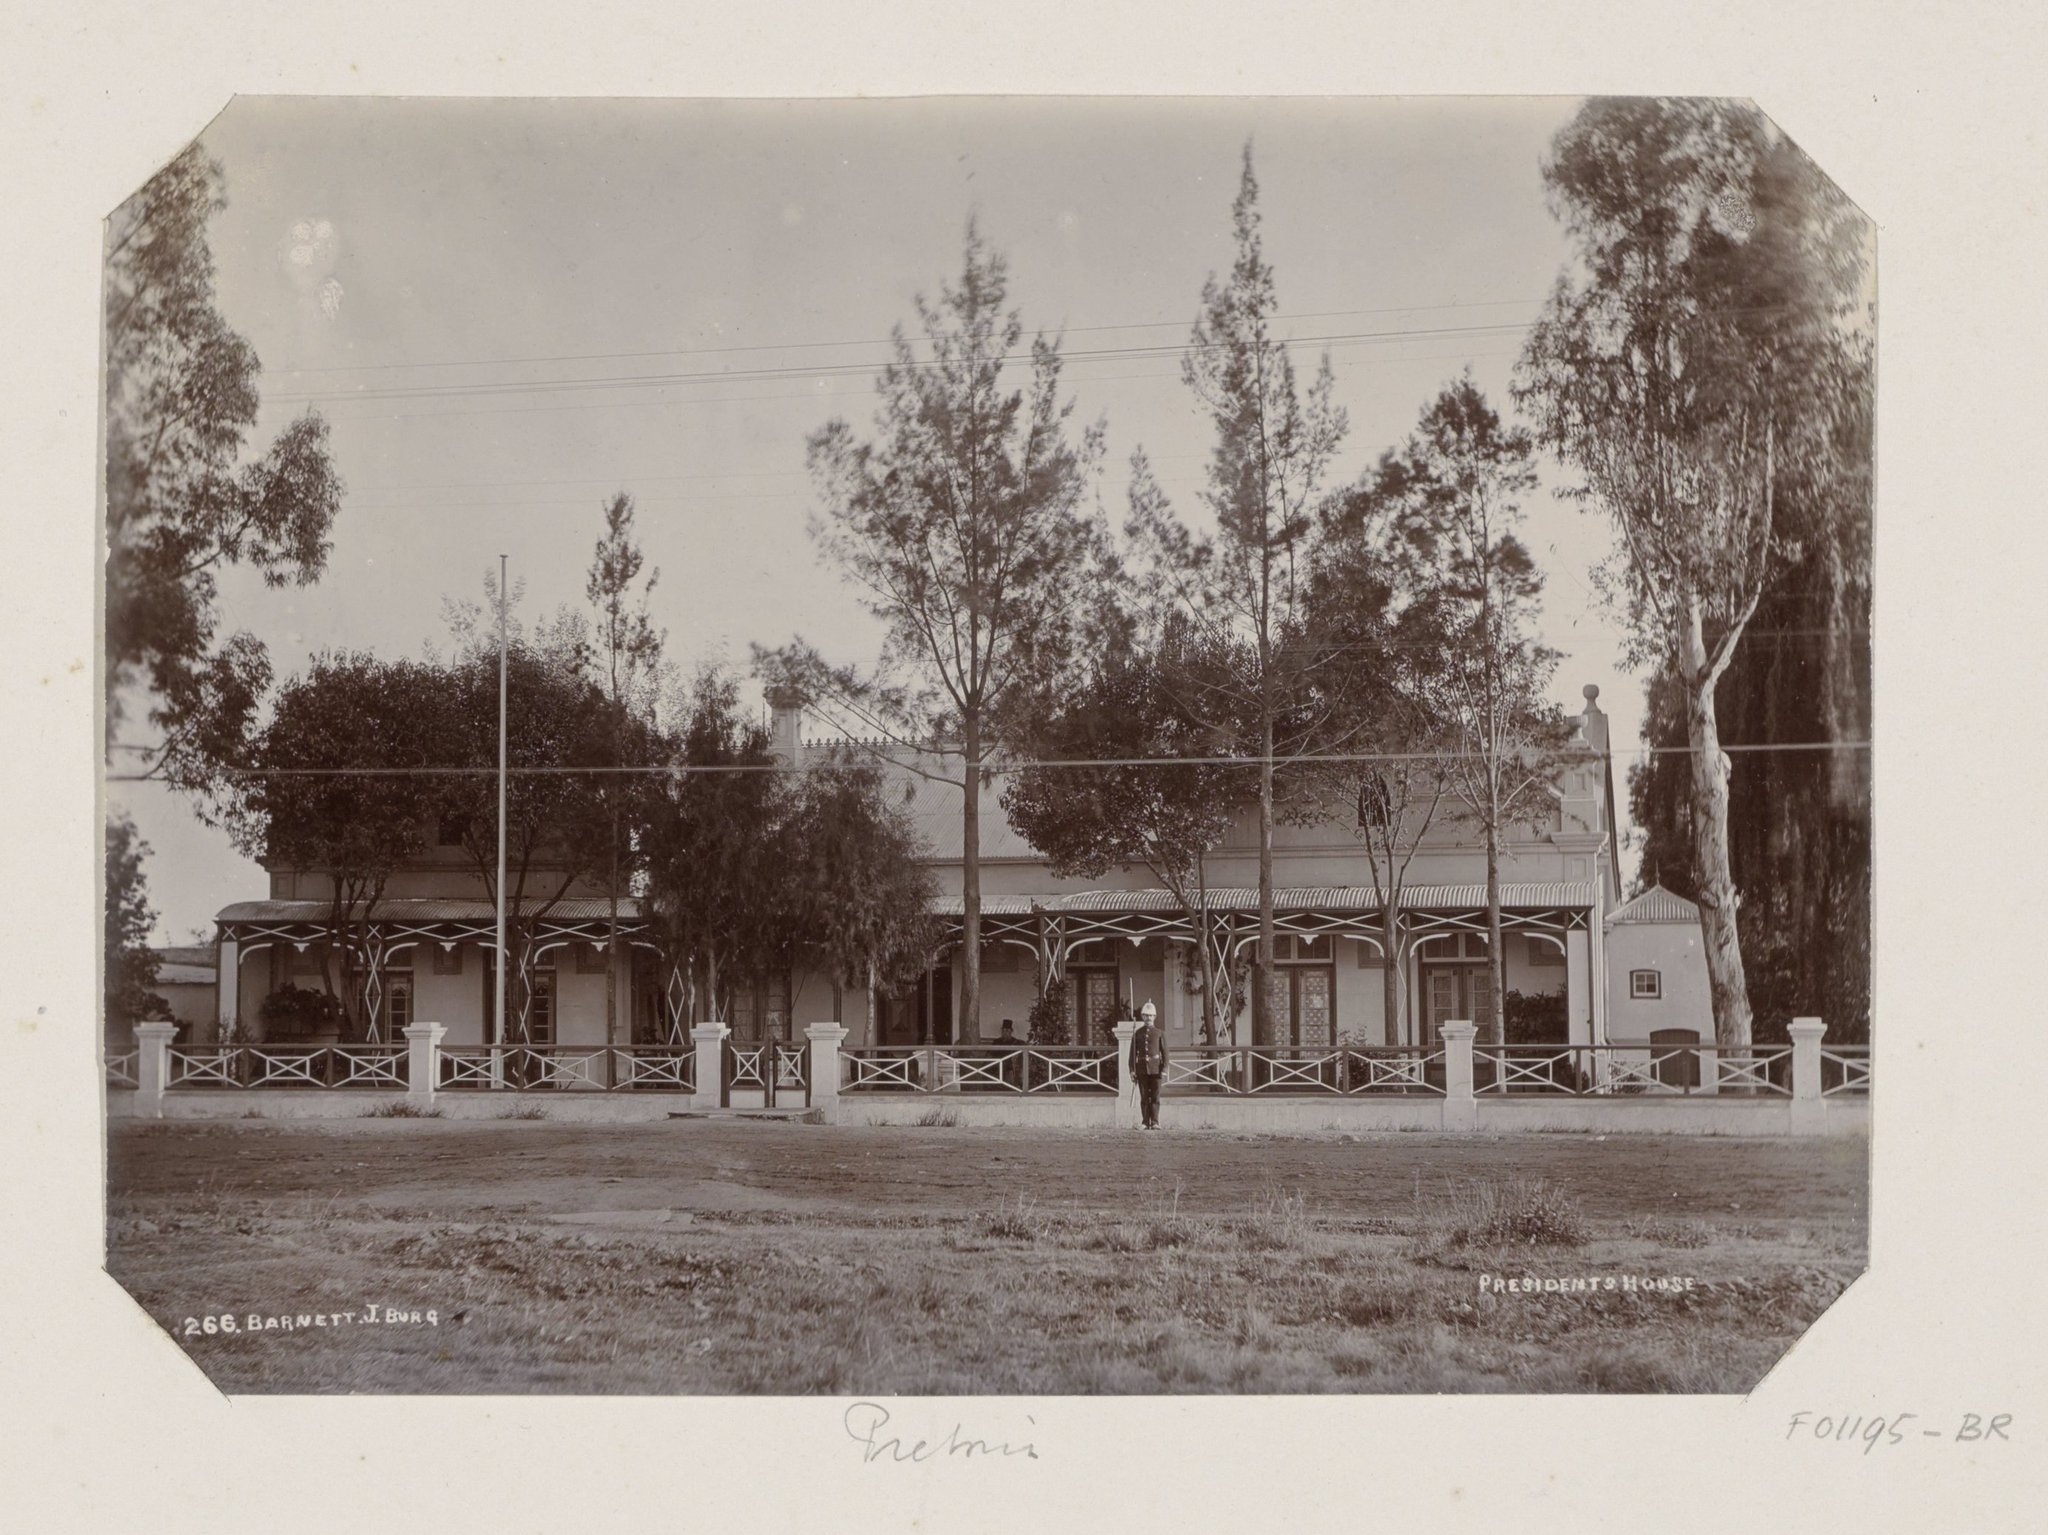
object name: photograph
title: Presidents House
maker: david barnett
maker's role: fotograaf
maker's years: -1964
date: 1884-1920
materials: cardboard, paper, photographic support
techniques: gelatin silver print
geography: pretoria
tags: exterior ~ representation of a building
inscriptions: negative number: ‘266’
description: Onderdeel van Fotoalbum van een reis door de Verenigde Staten, Honolulu, Nederlands-Indië, Aden, Zanzibar en Zuidelijk Afrika.